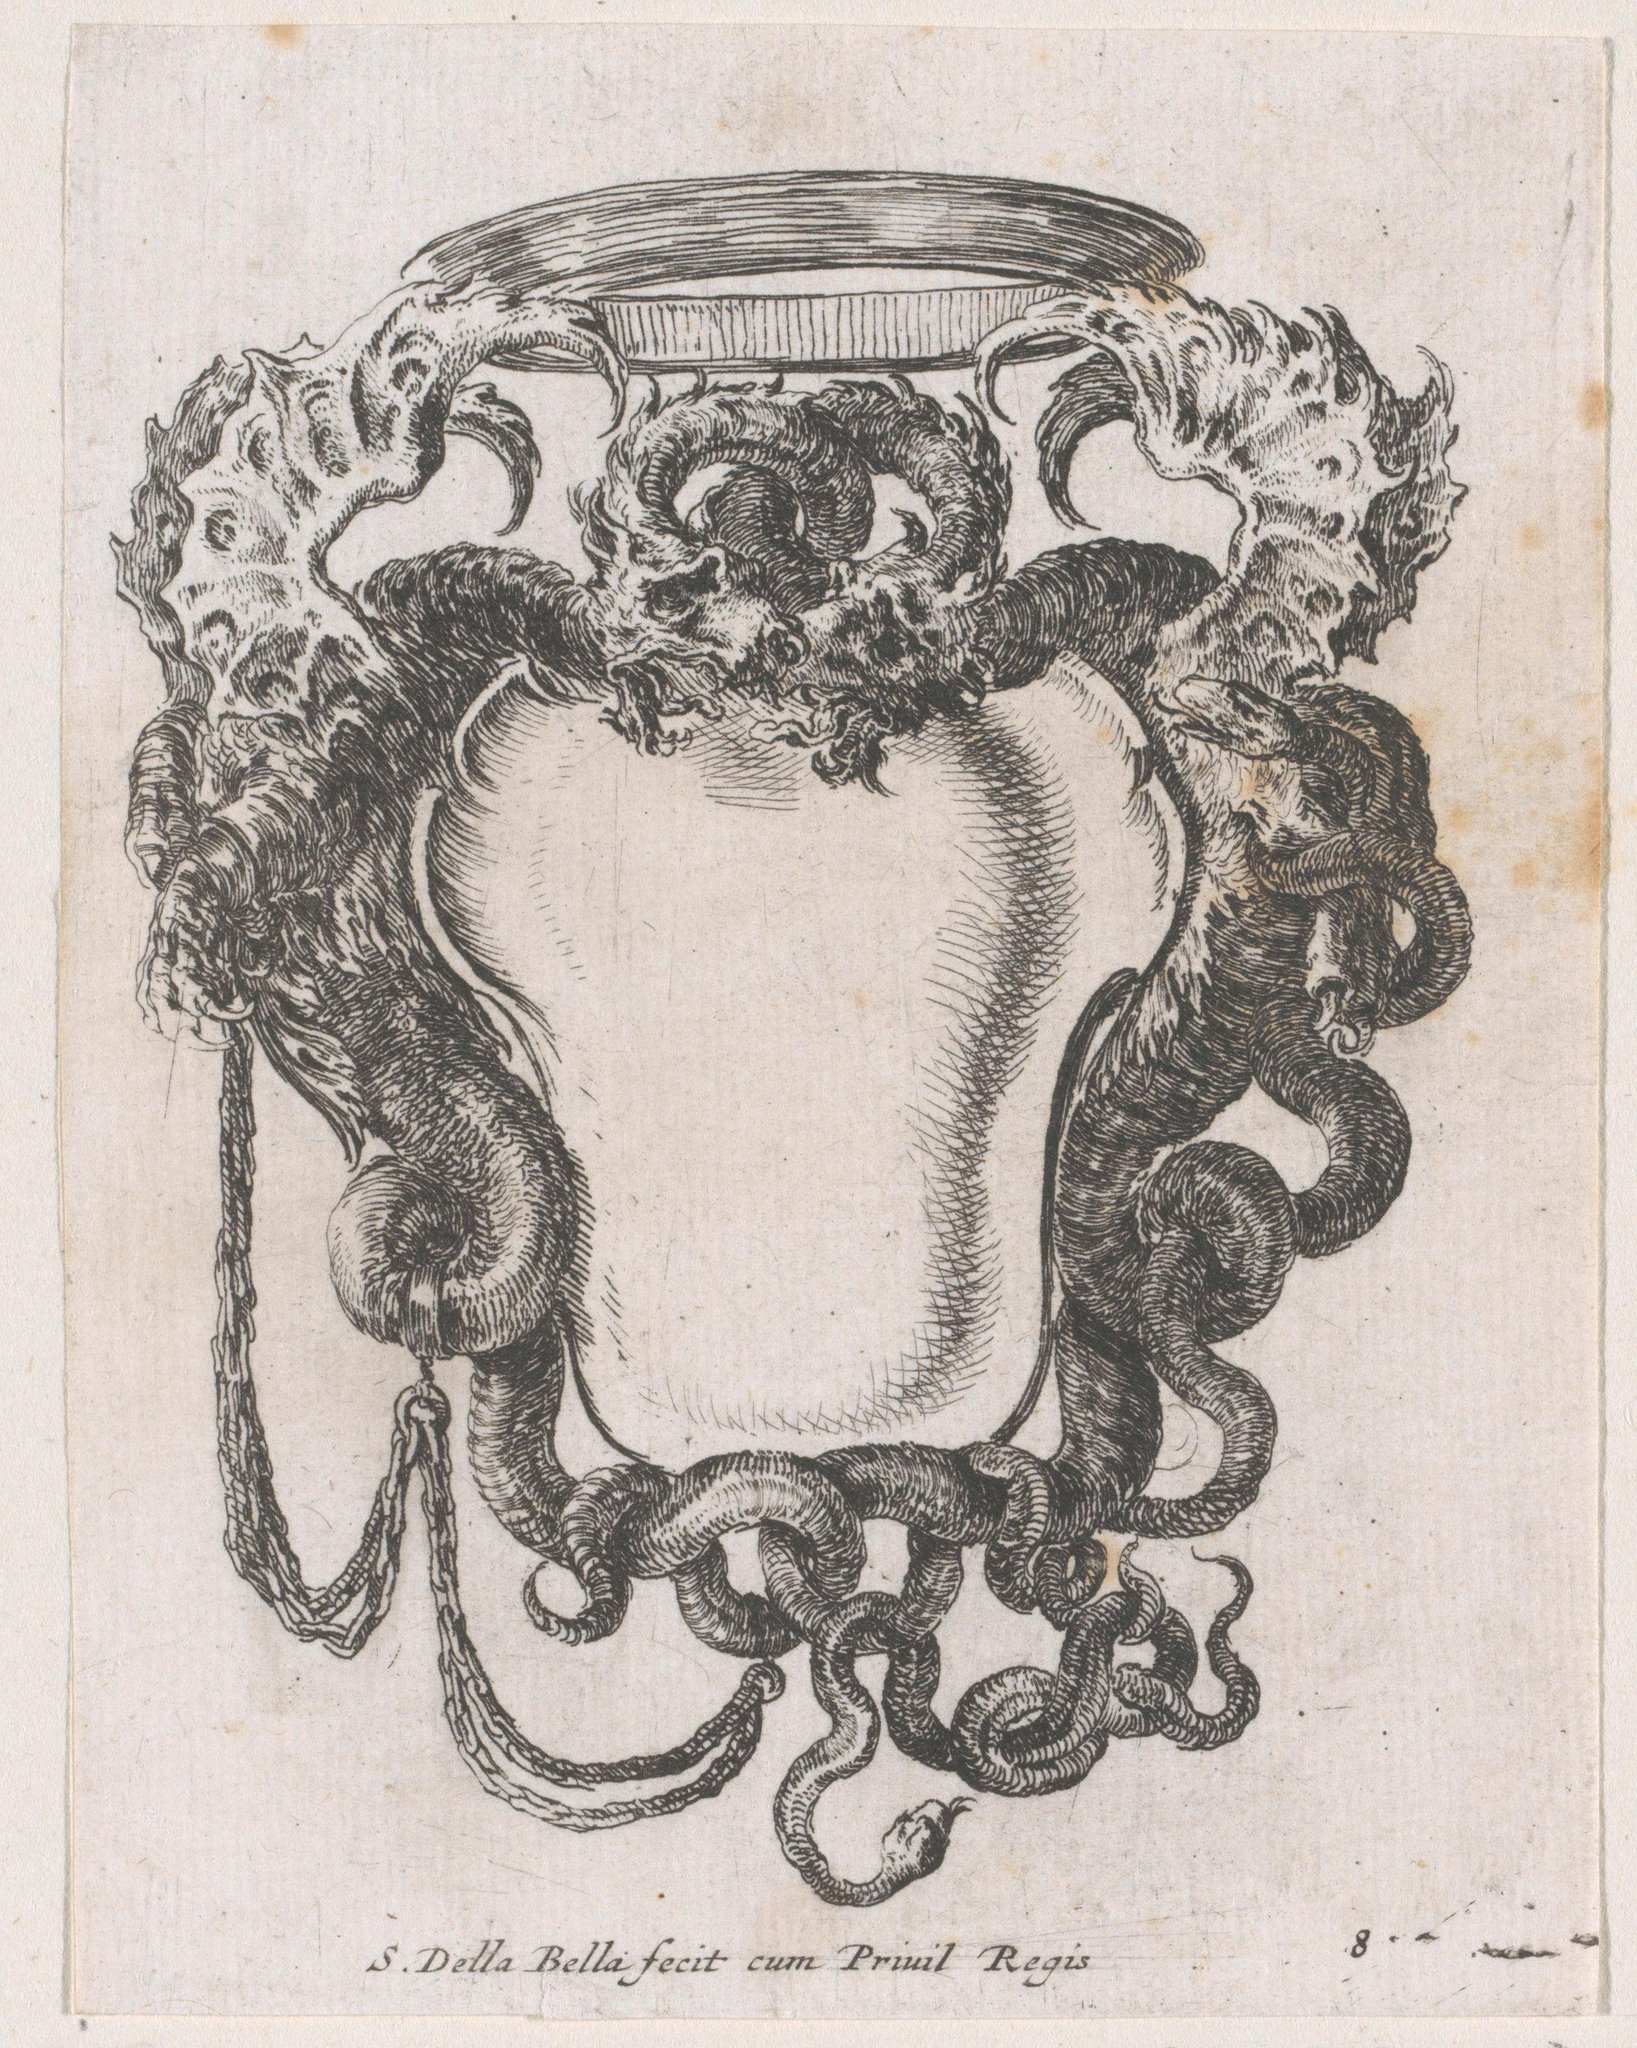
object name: ornament print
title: Nouvelles inventions de cartouches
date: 1647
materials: paper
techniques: etching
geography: france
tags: crown (symbol of sovereignty), ornament ~ cartouche, dragon